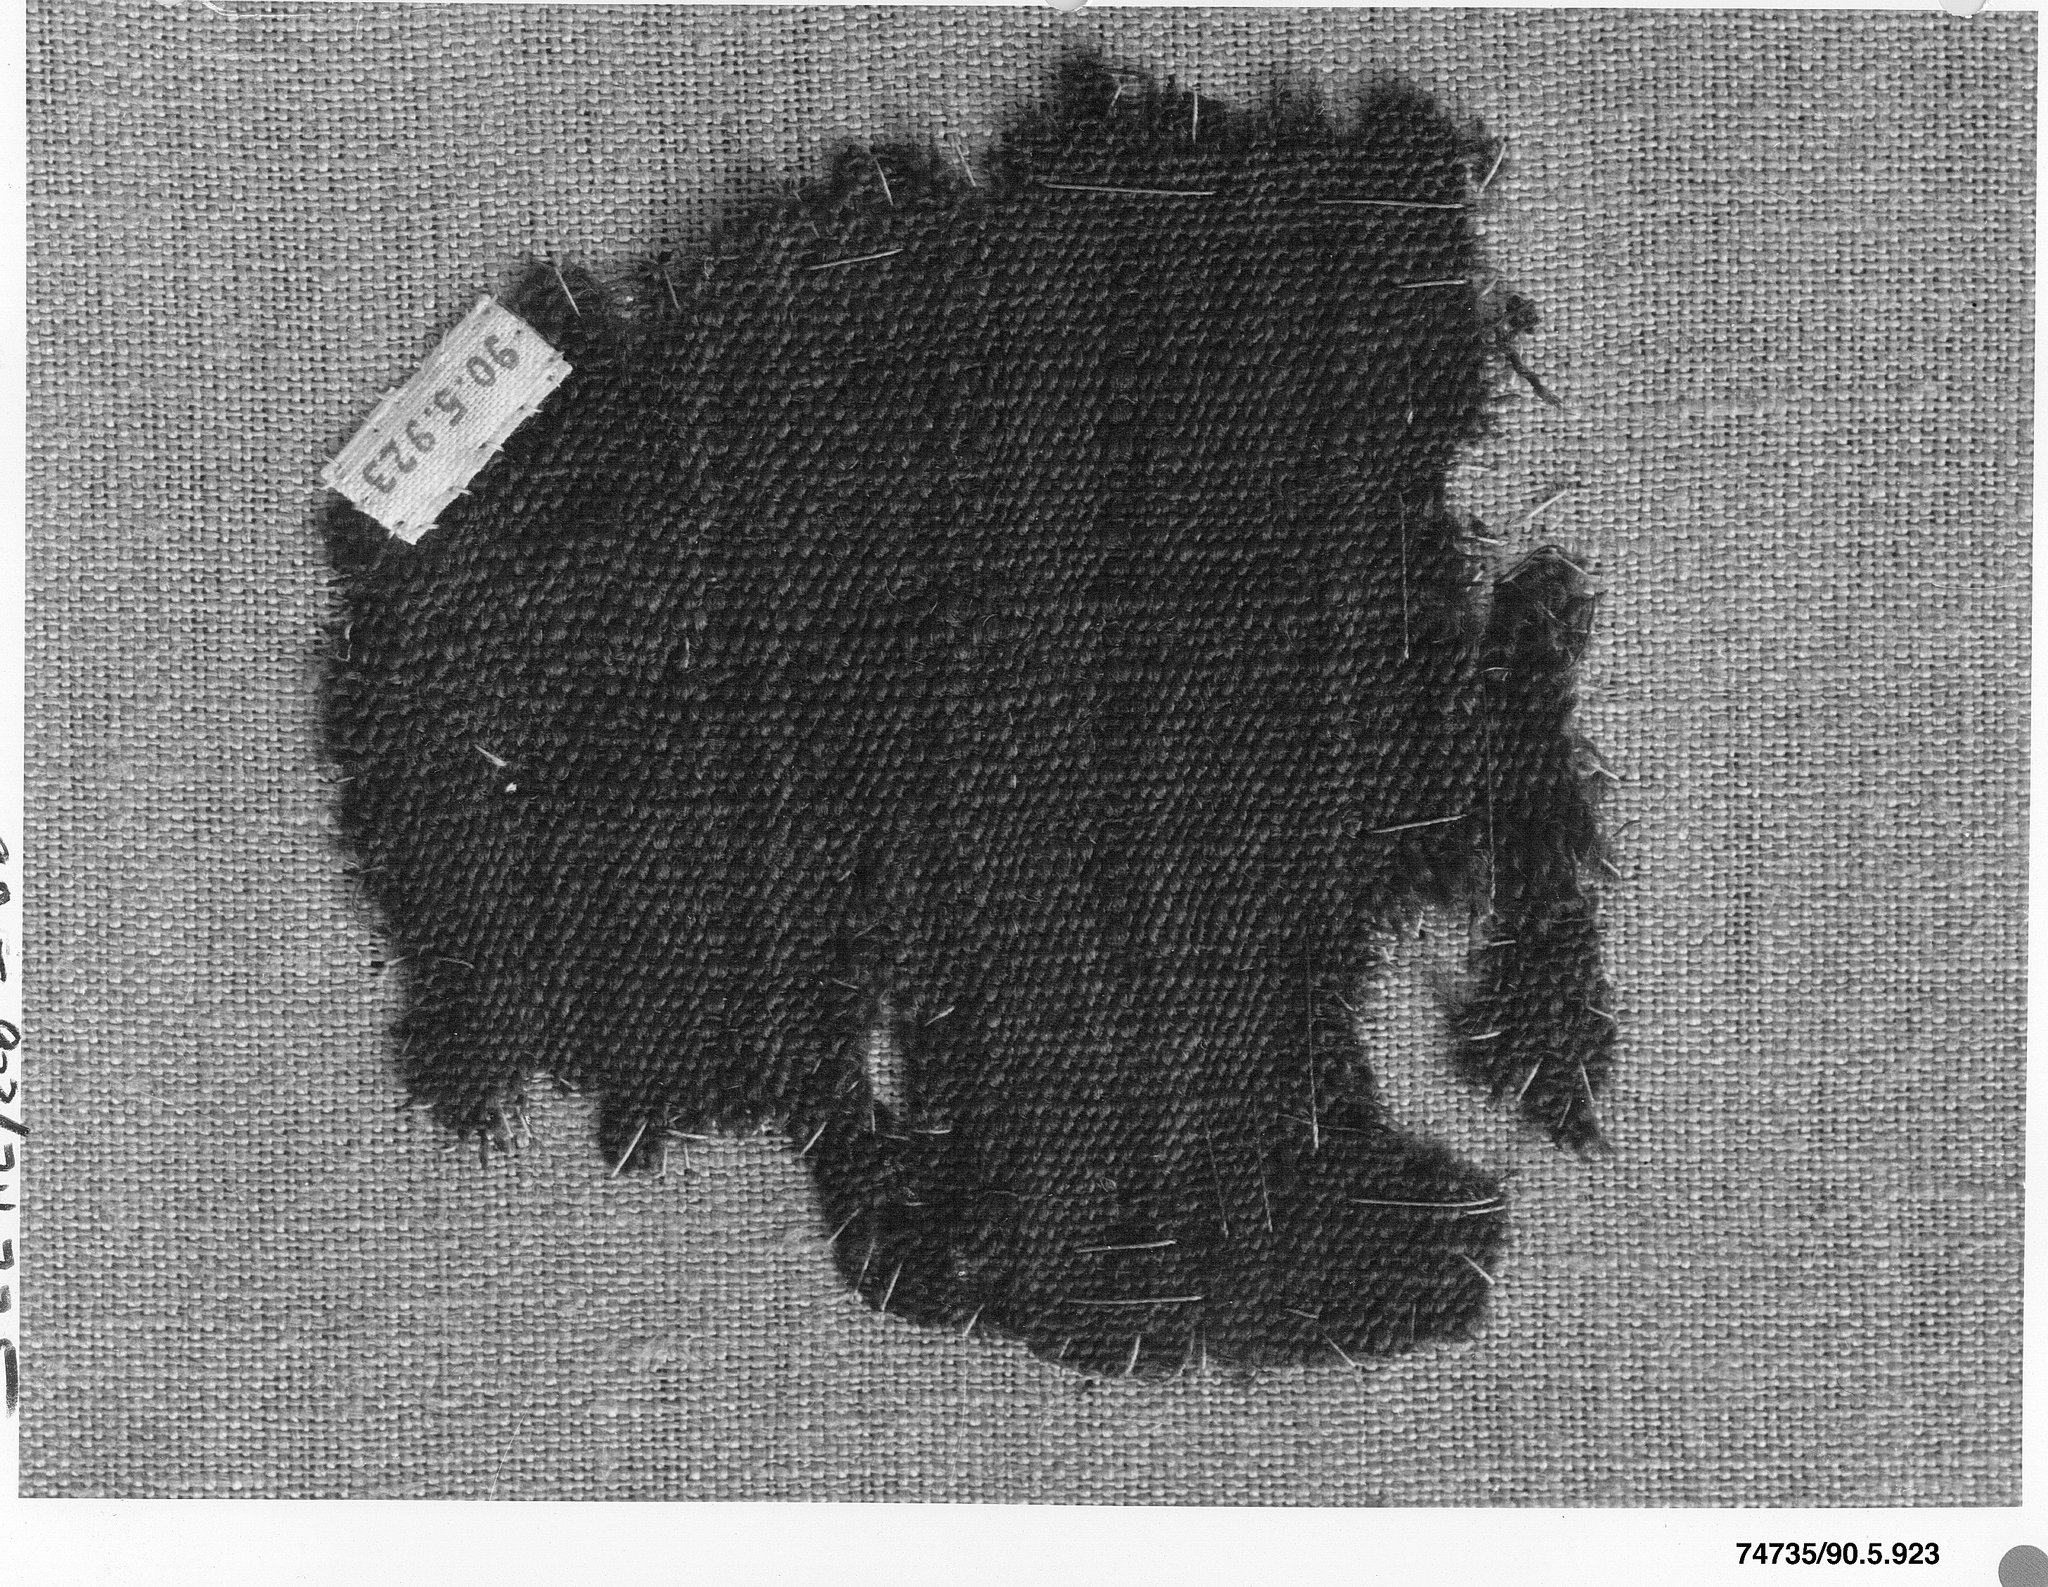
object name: textile fragment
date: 501-600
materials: wool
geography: egypt